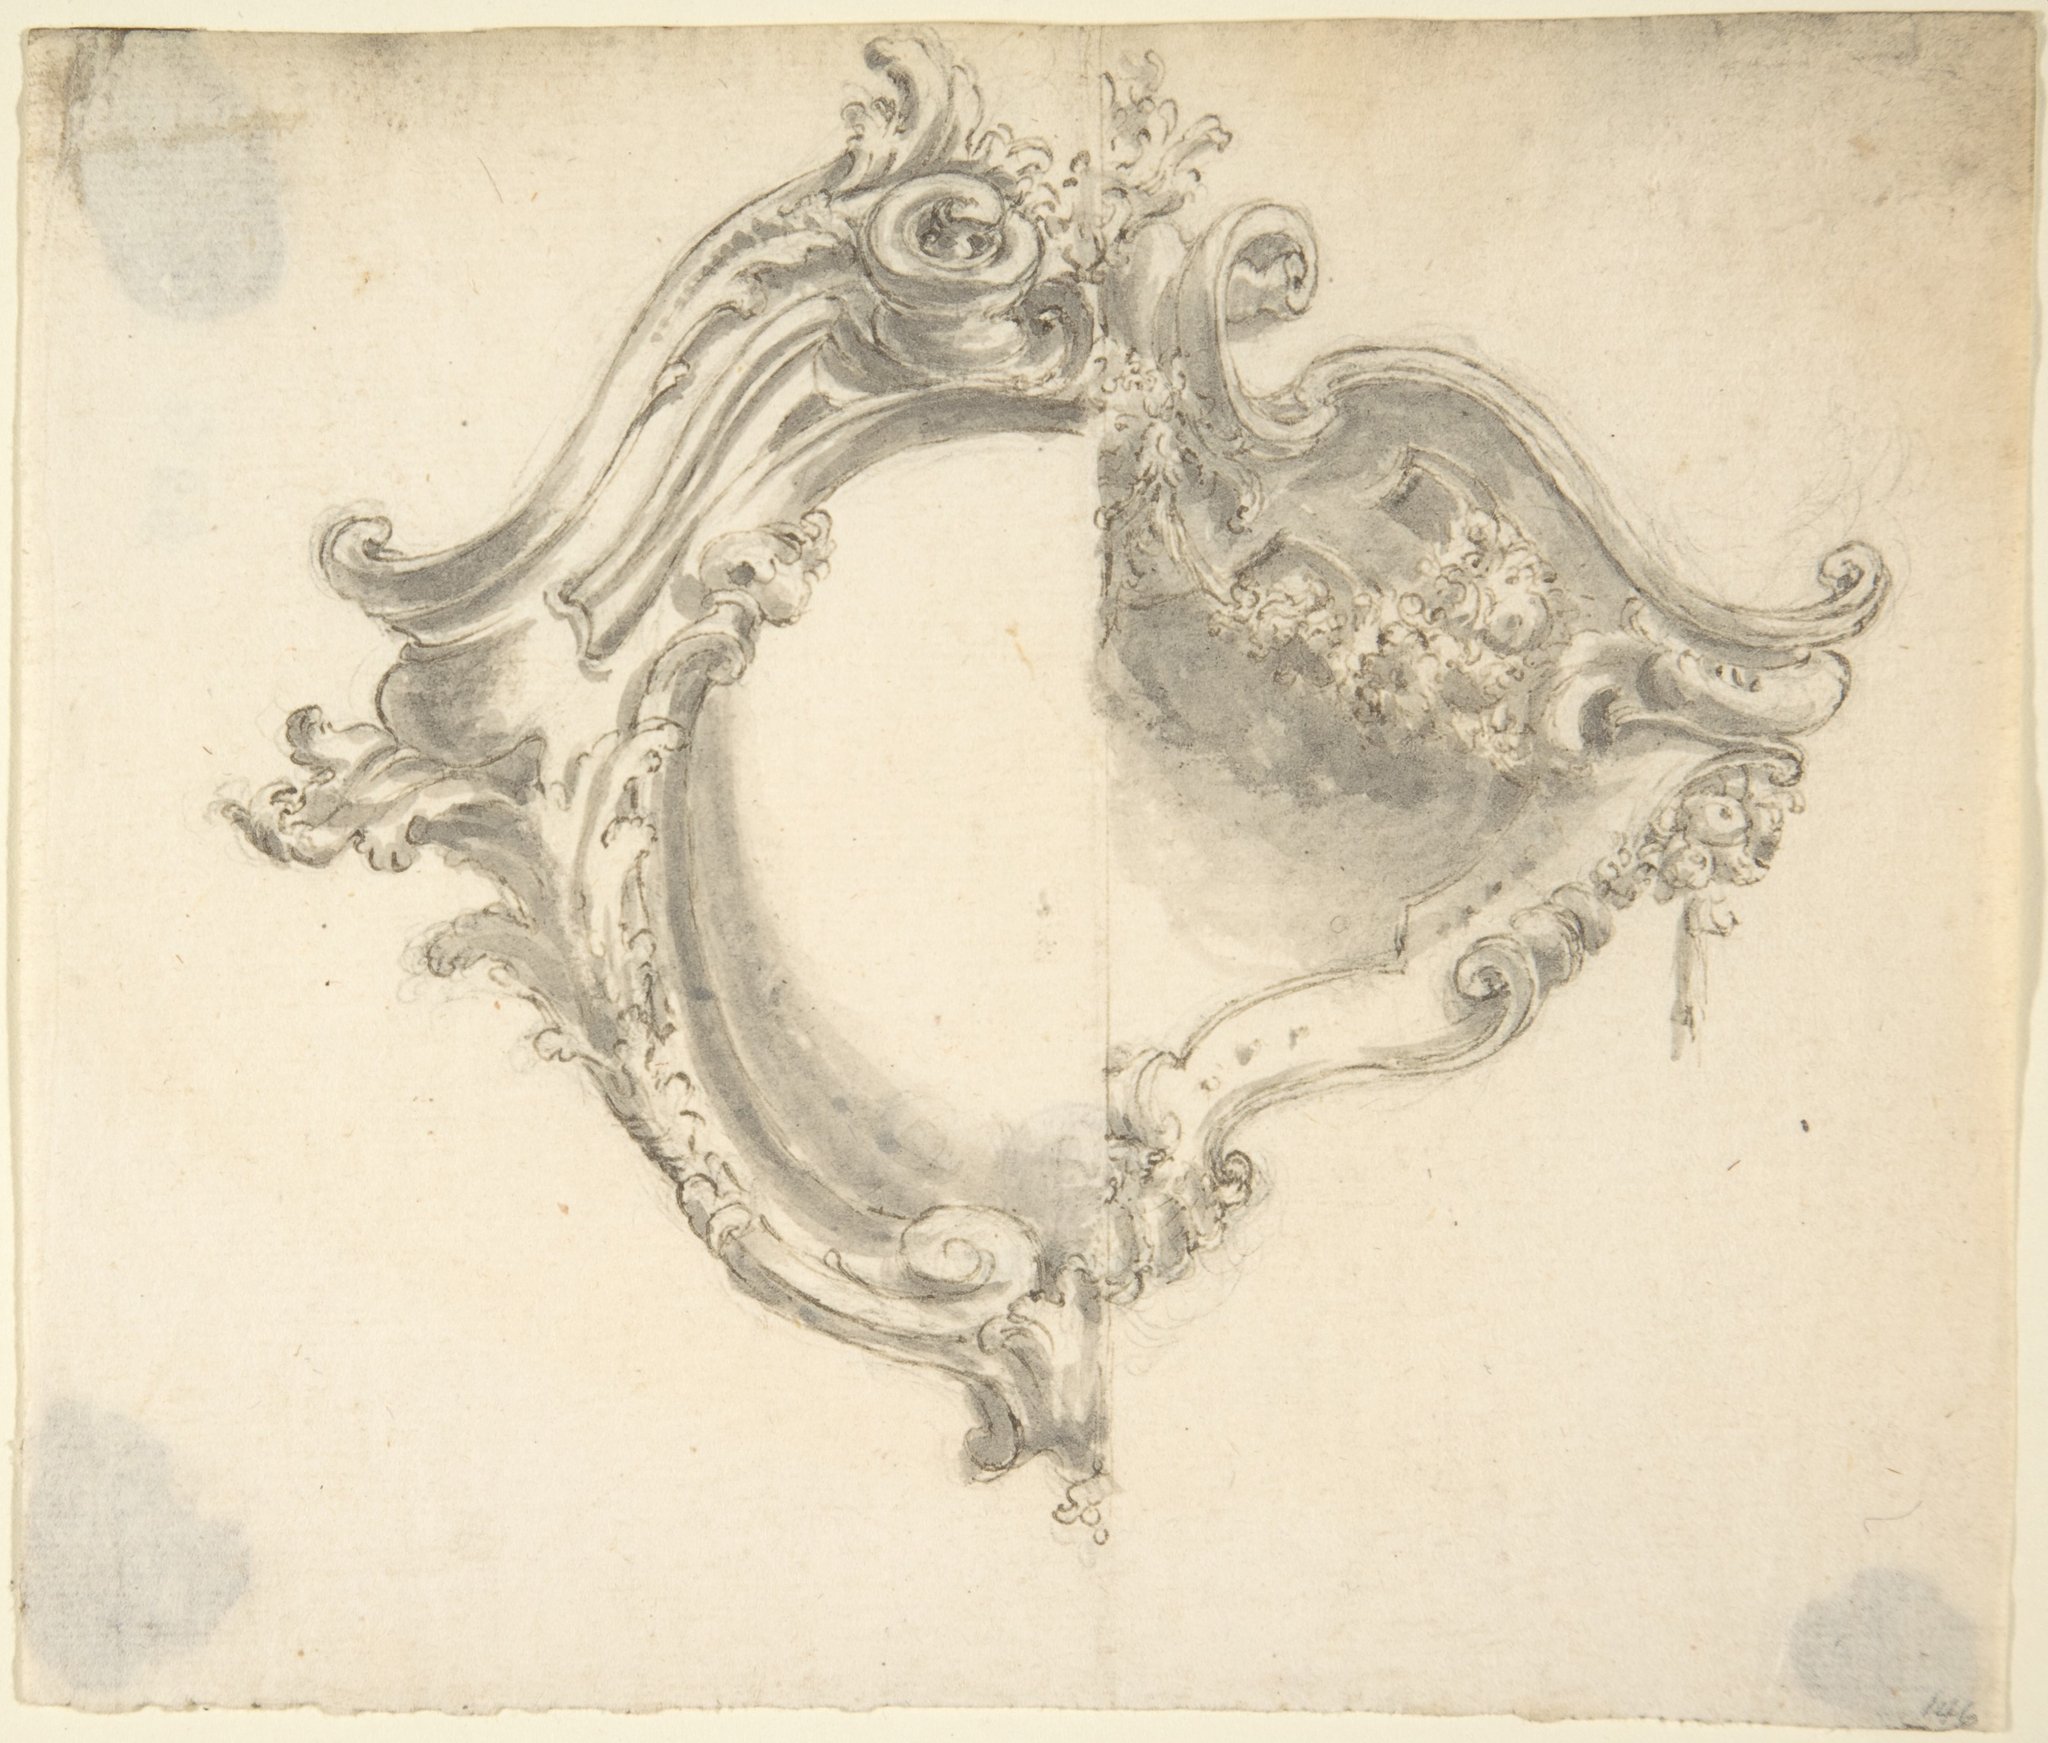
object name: drawing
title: Two Variant Half Designs for a Cartouche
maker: anonymous, italian, piedmontese, 18th century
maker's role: artist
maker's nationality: italian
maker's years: 1700-1800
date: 1700-1780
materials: graphite, ink, lead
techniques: brush, pen, wash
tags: cartouches